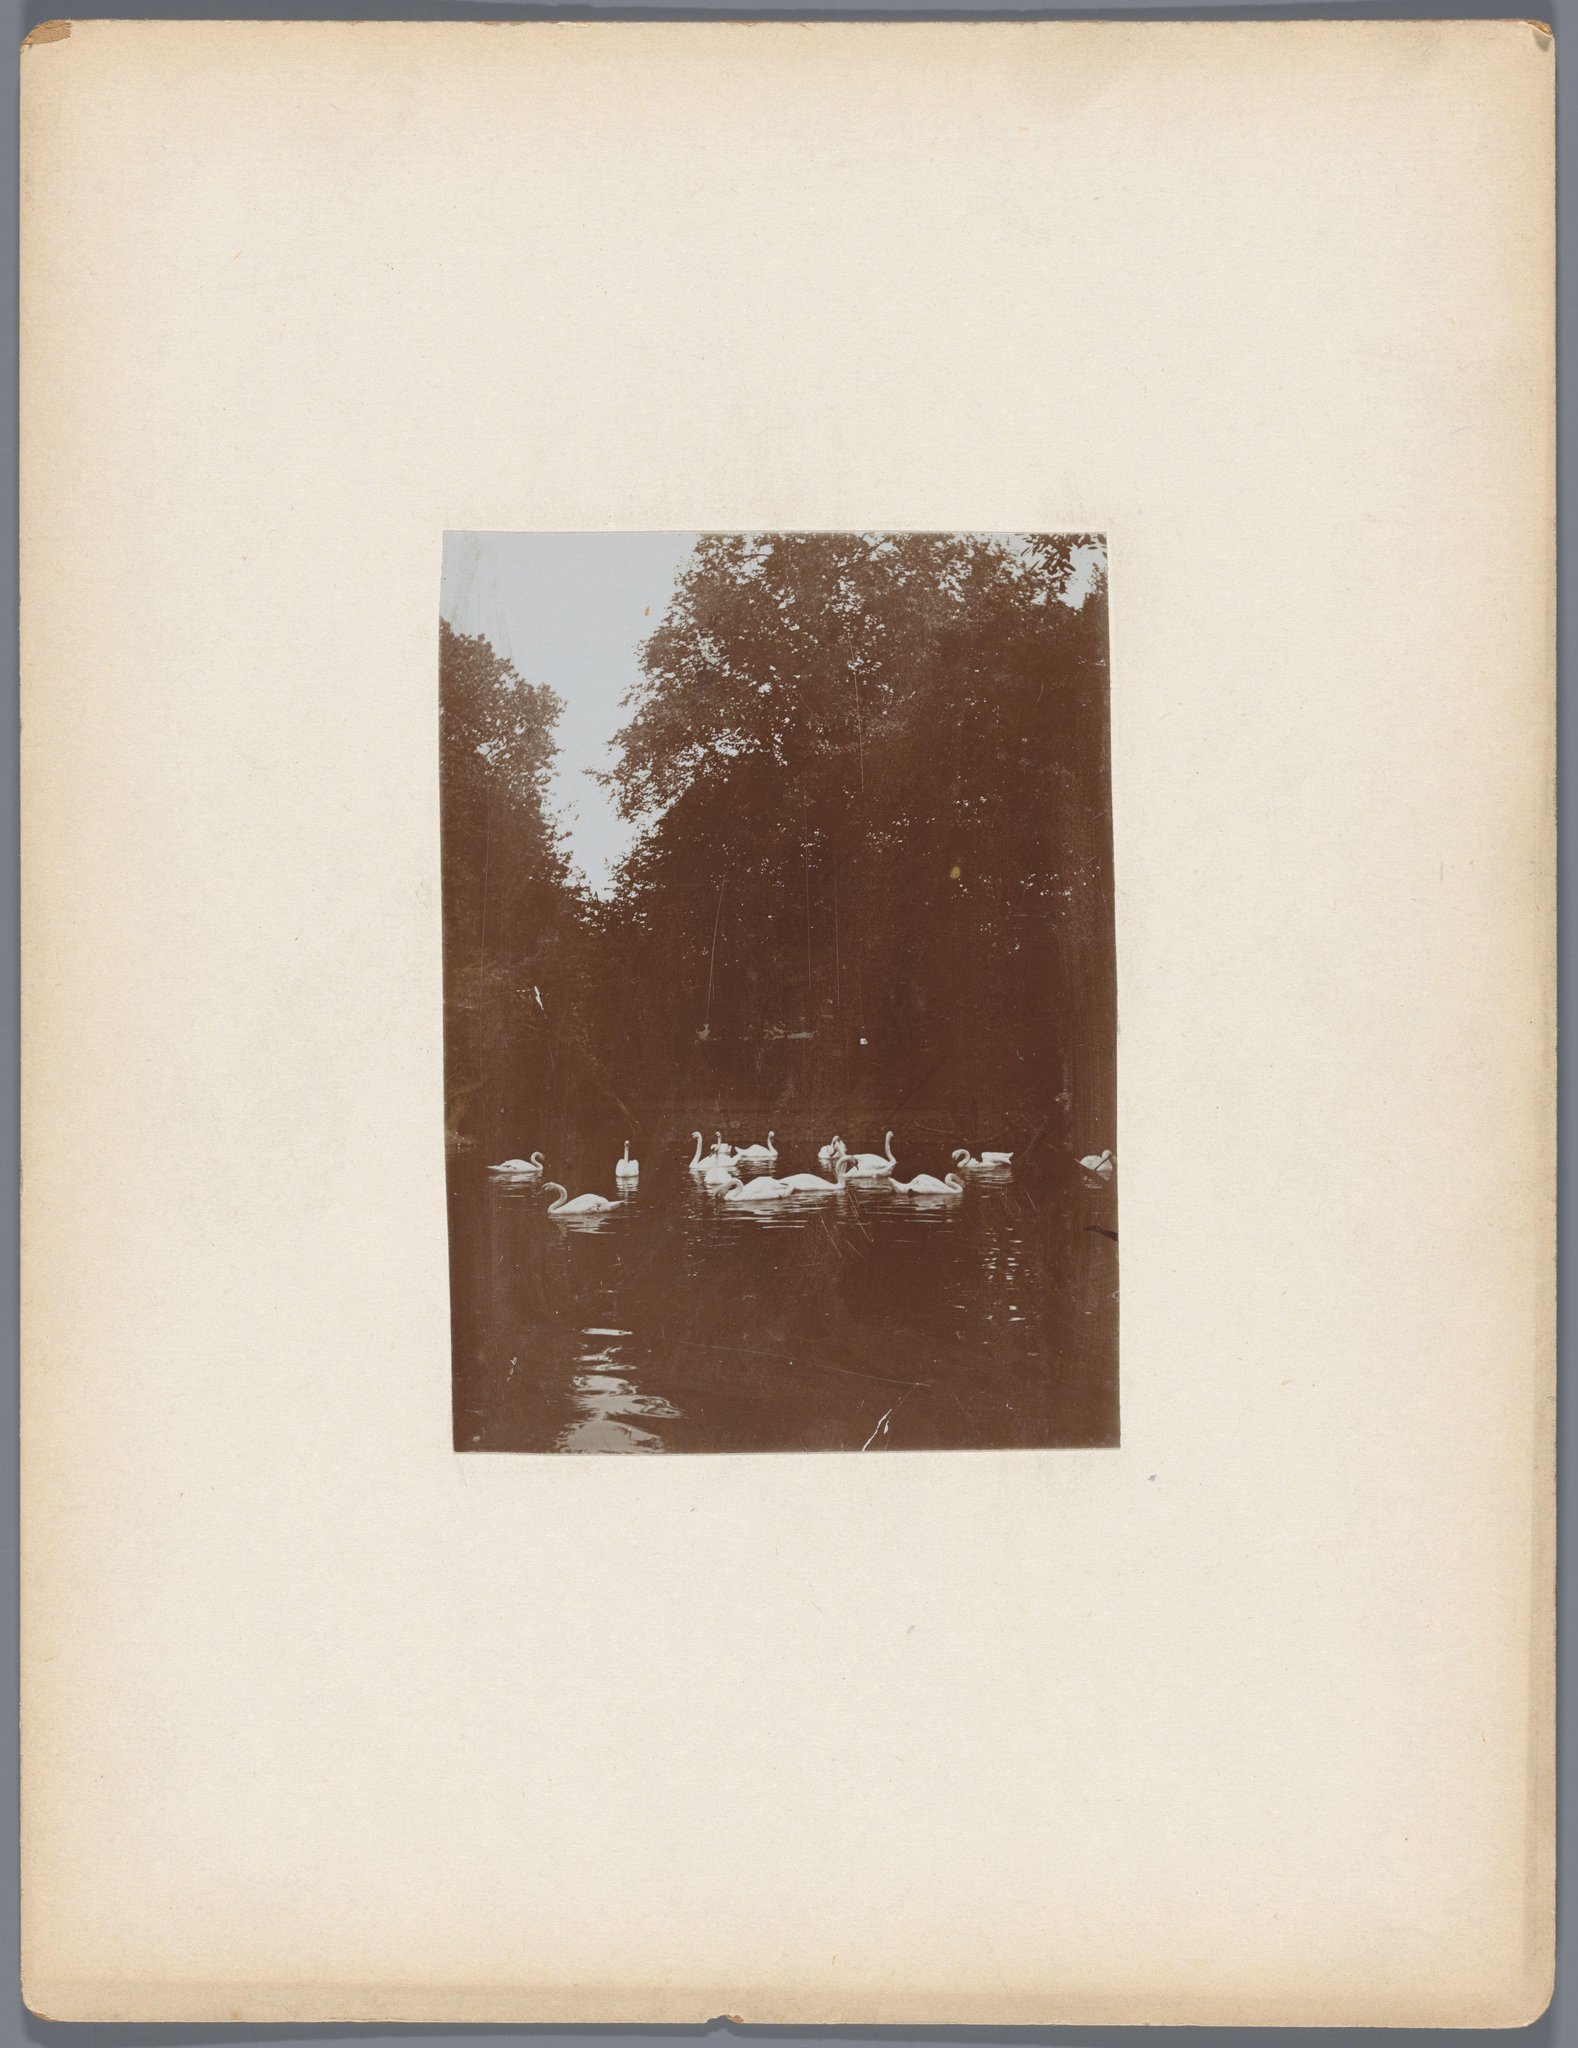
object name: photograph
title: Vijver met zwanen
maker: Anonymous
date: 1907-1910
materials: cardboard, photographic support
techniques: collodion silver print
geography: netherlands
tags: water-birds: swan, netherlands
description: Vijver met zwanen. Onderdeel van het losbladige fotoalbum met 39 foto's van een reis door Nederland, ca. 1907-1910.